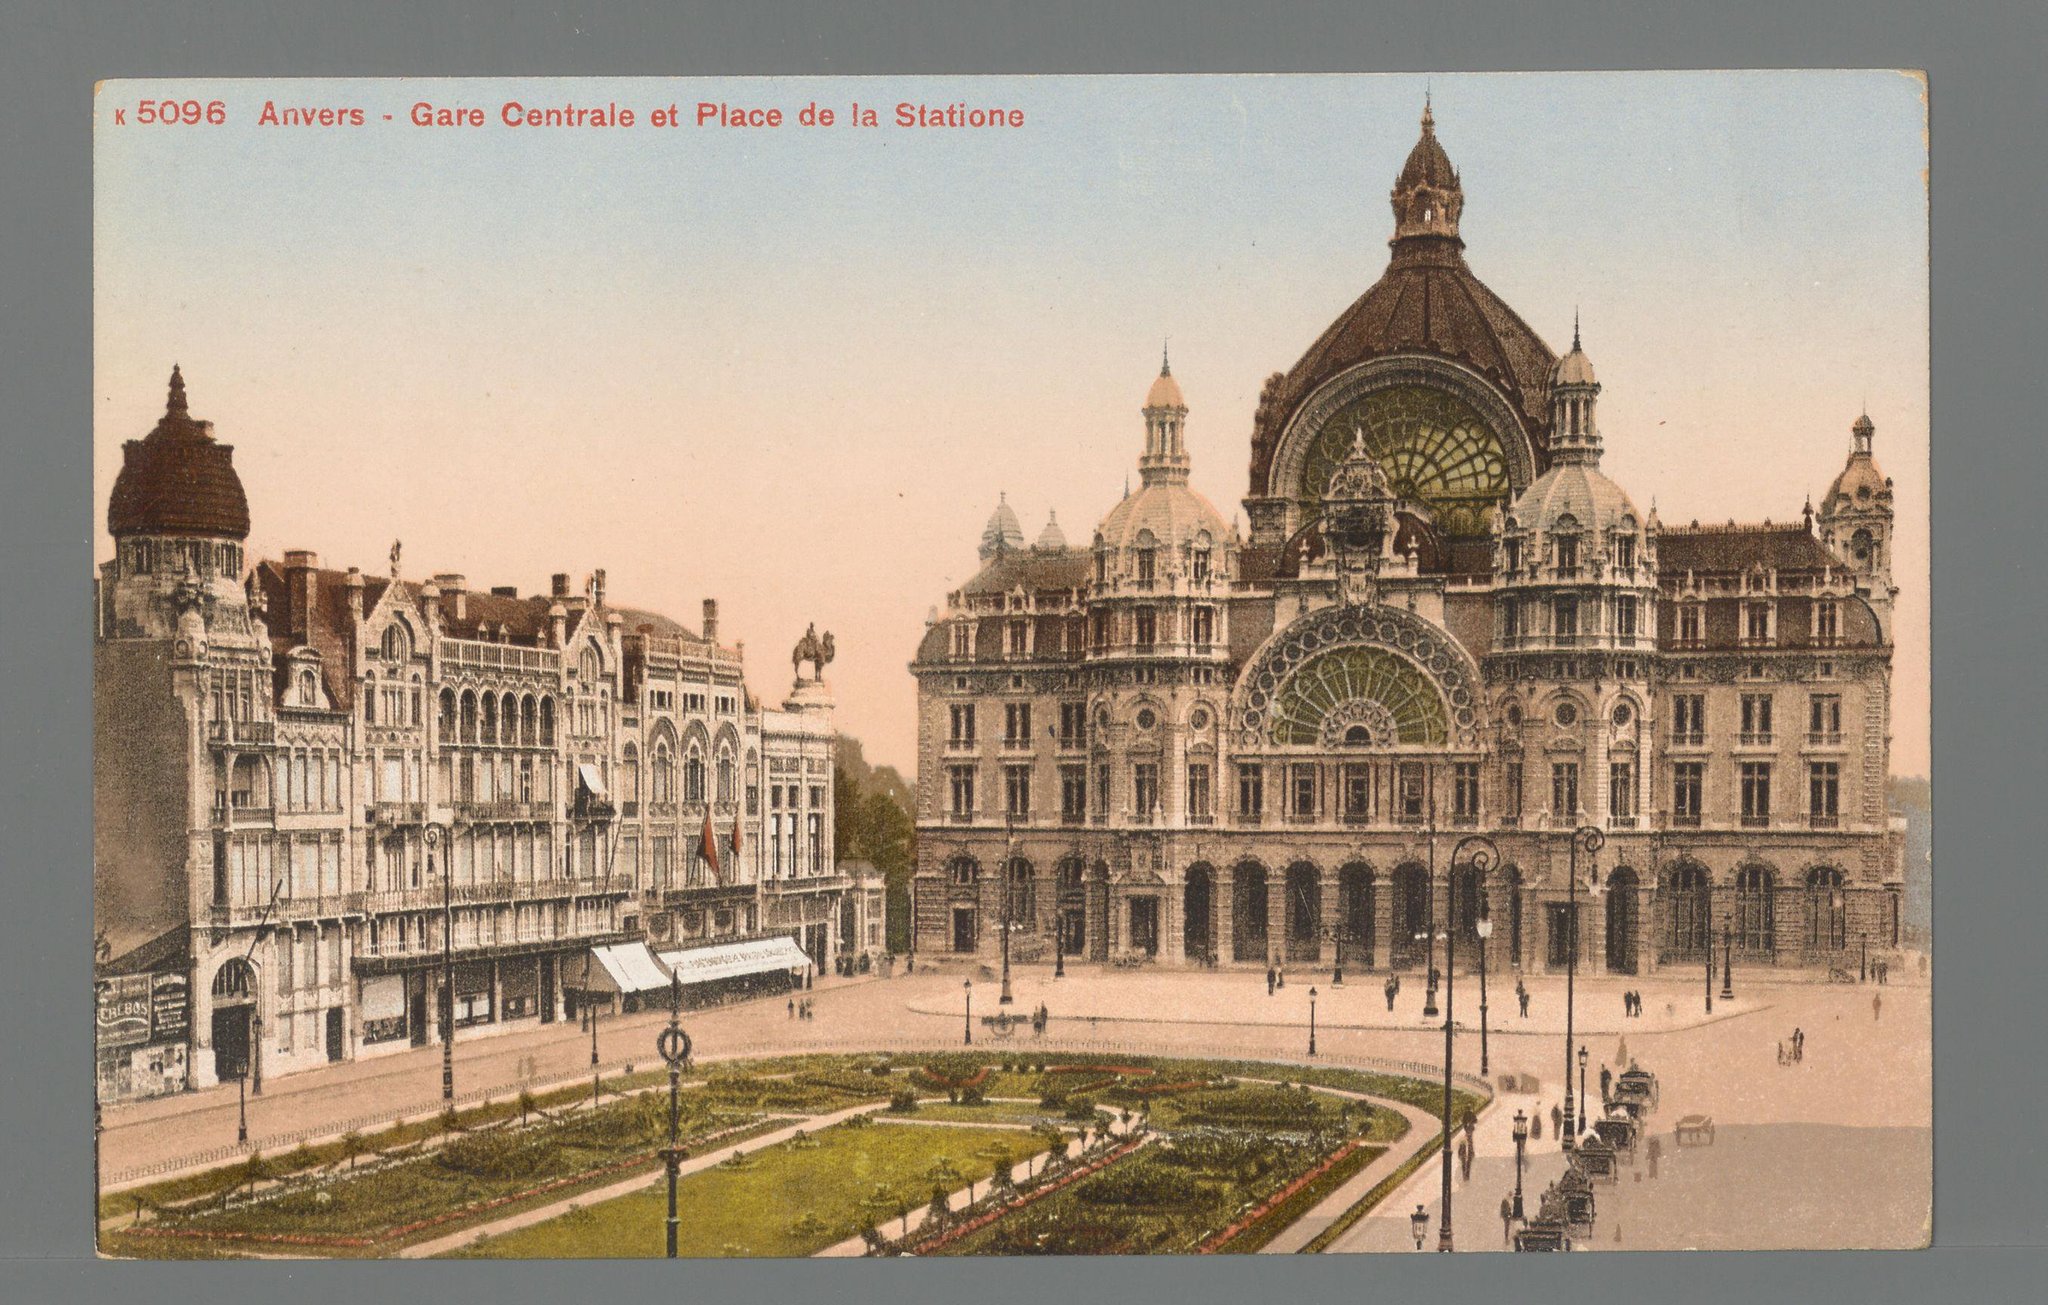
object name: ansichtkaart, prentbriefkaart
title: Anvers. Gare Centrale et Place de la Statione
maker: Anonymous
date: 1905-1930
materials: cardboard, photographic process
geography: antwerp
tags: square, place, circus, etc., station; shelter (railway, tramway), city-view, and landscape with man-made constructions (+ city(-scape) with figures, staffage), antwerp